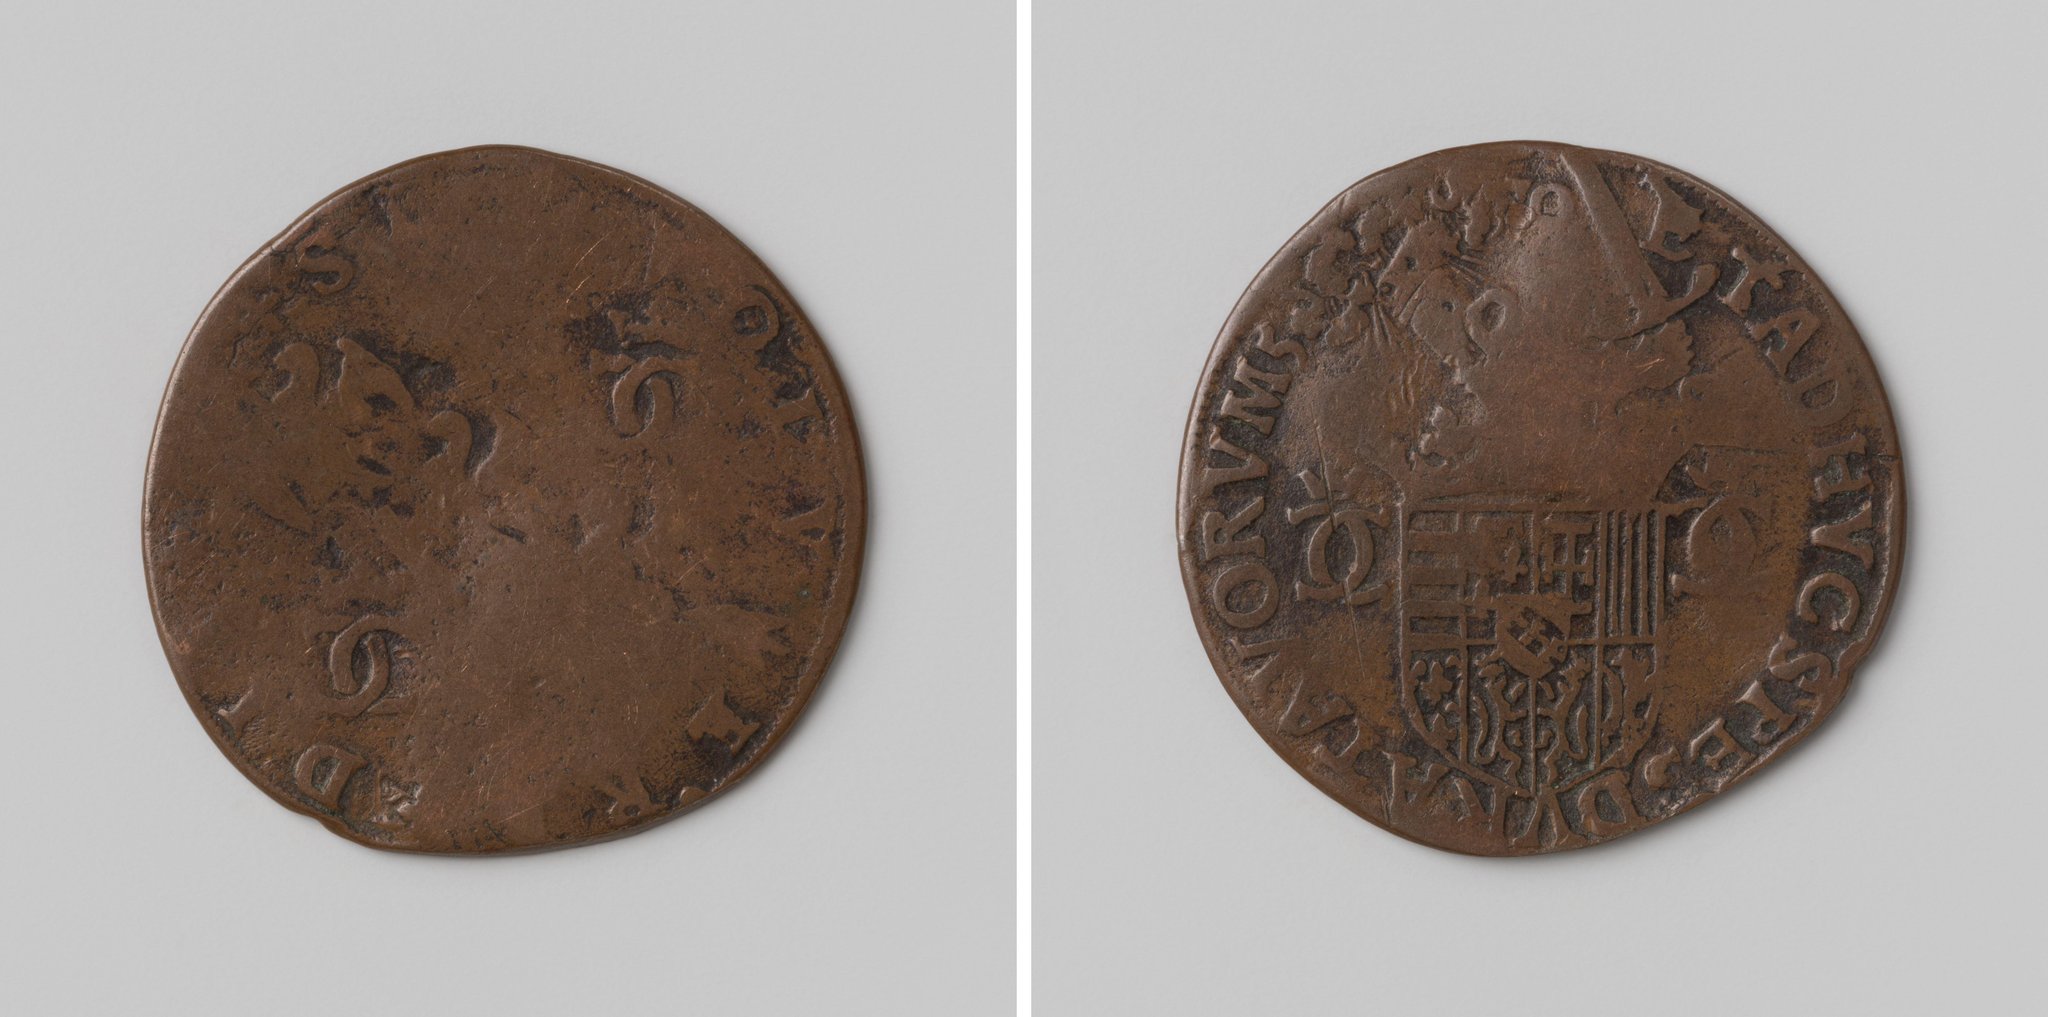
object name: jeton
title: Claudius van Lotharingen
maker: Anonymous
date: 1570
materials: copper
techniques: striking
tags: claudius van lotharingen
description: Koperen penning. Voorzijde: drie vleugels doorboord door pijl; daaromheen twee verweven letters C onder kroon binnen omschrift. Keerzijde: wapenschild onder arm met zwaard in hand tussen twee verweven letters C onder kroon binnen omschrift